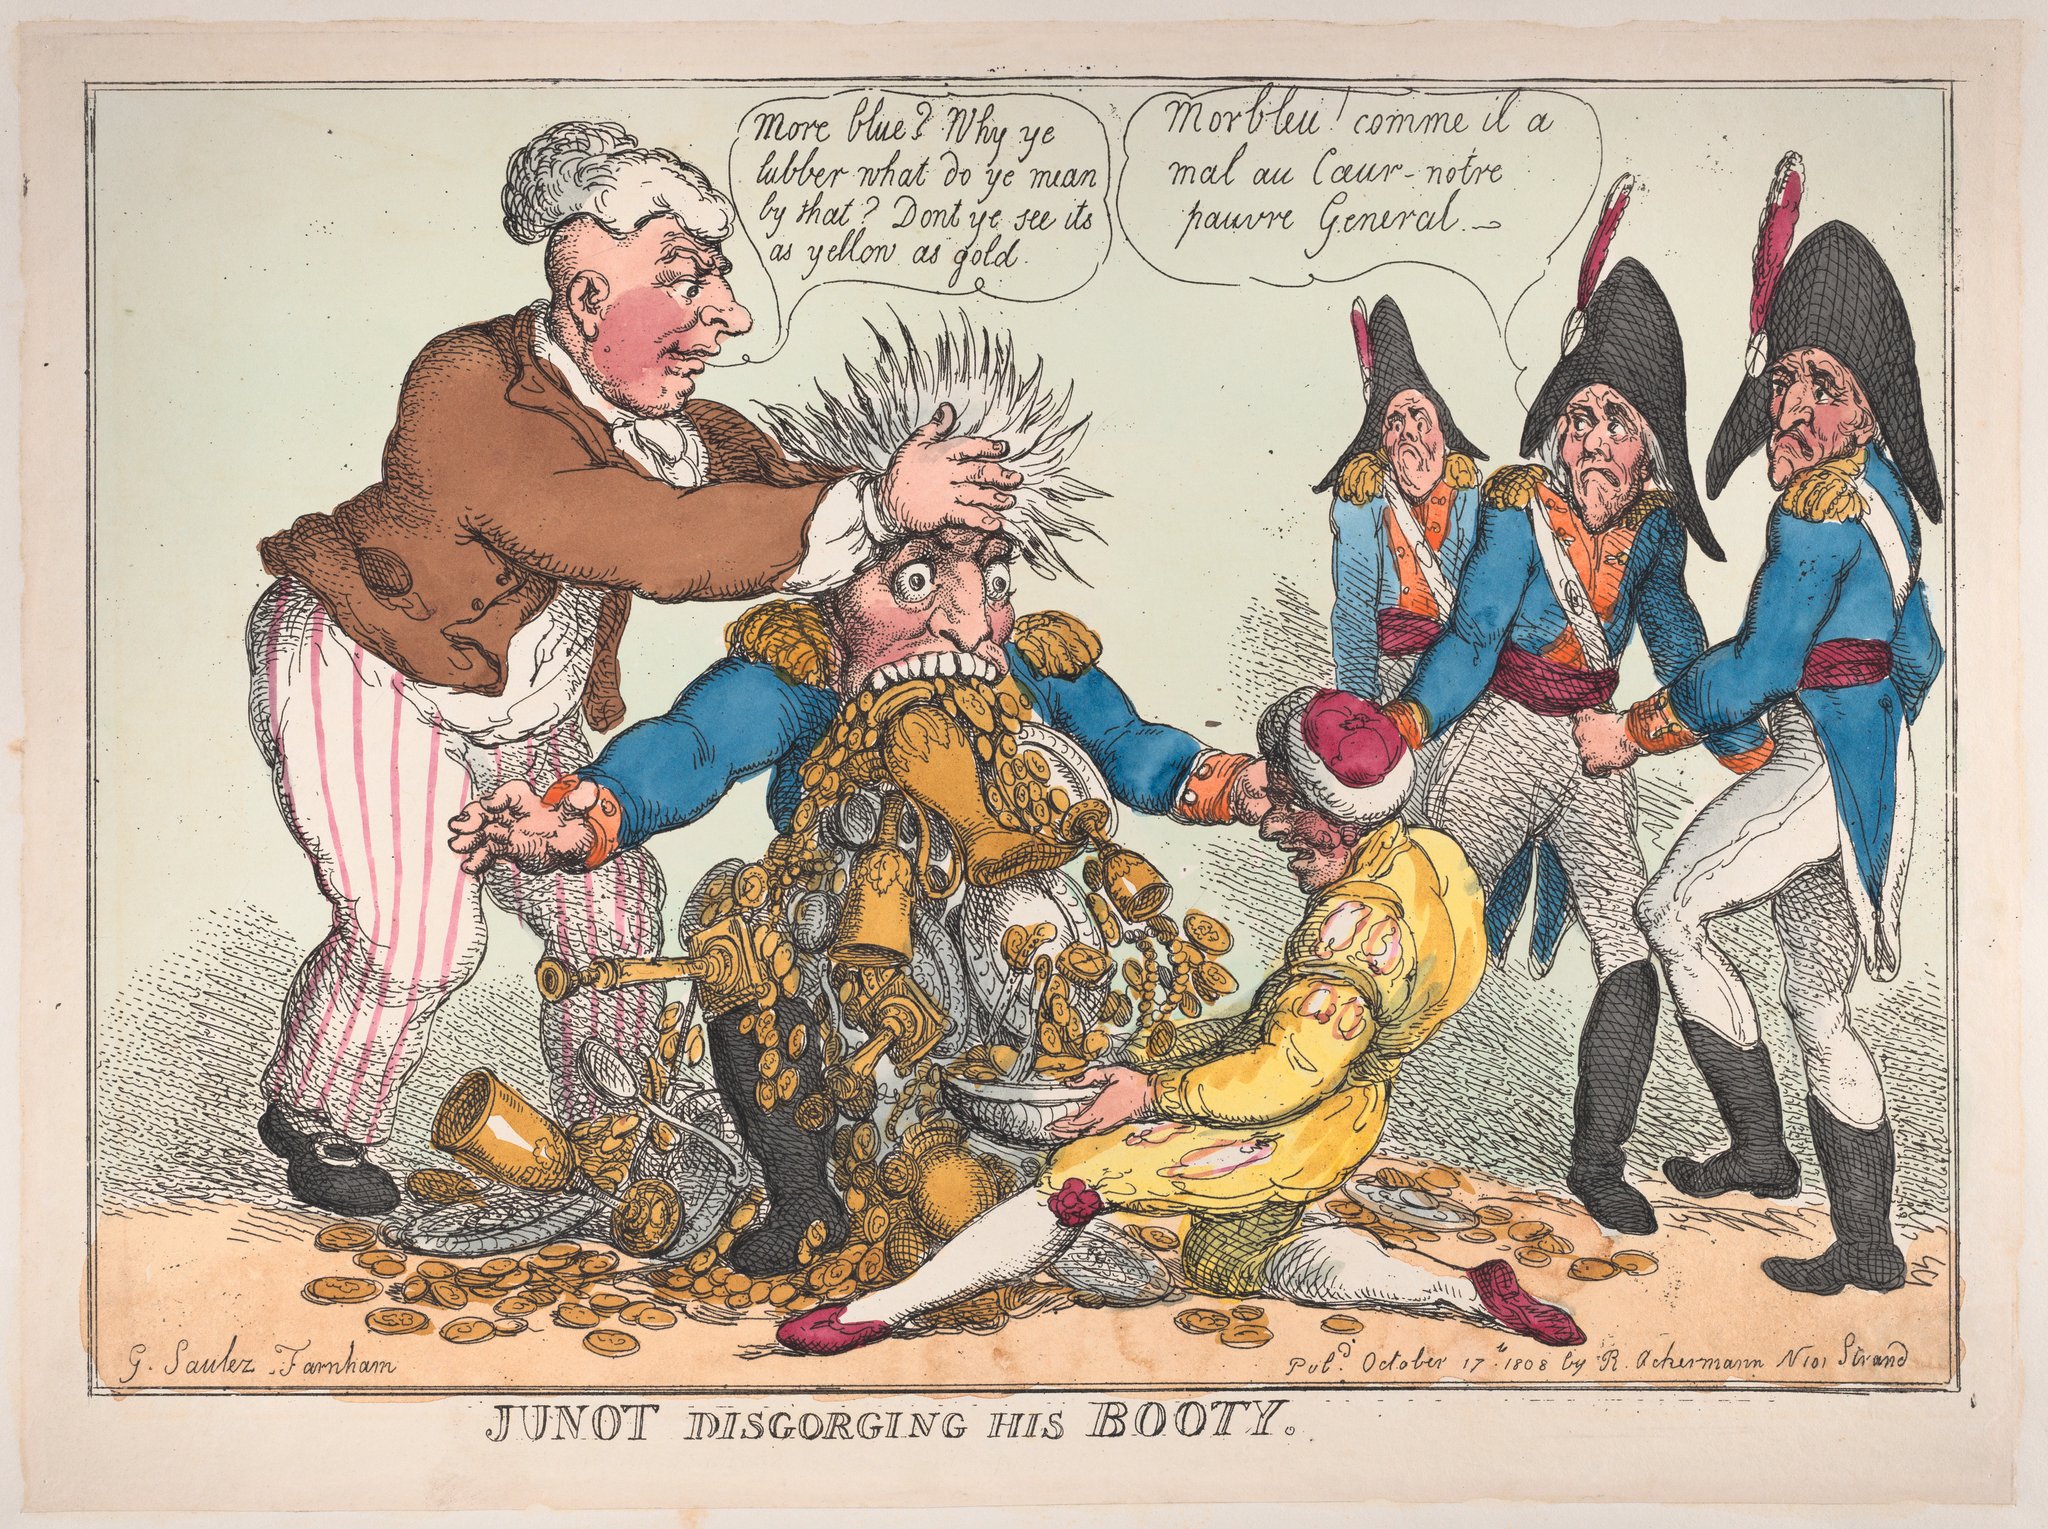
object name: print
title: Junot Disgorging His Booty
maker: thomas rowlandson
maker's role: artist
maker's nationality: british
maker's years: 1757-1827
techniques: etching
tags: satire,men,politics